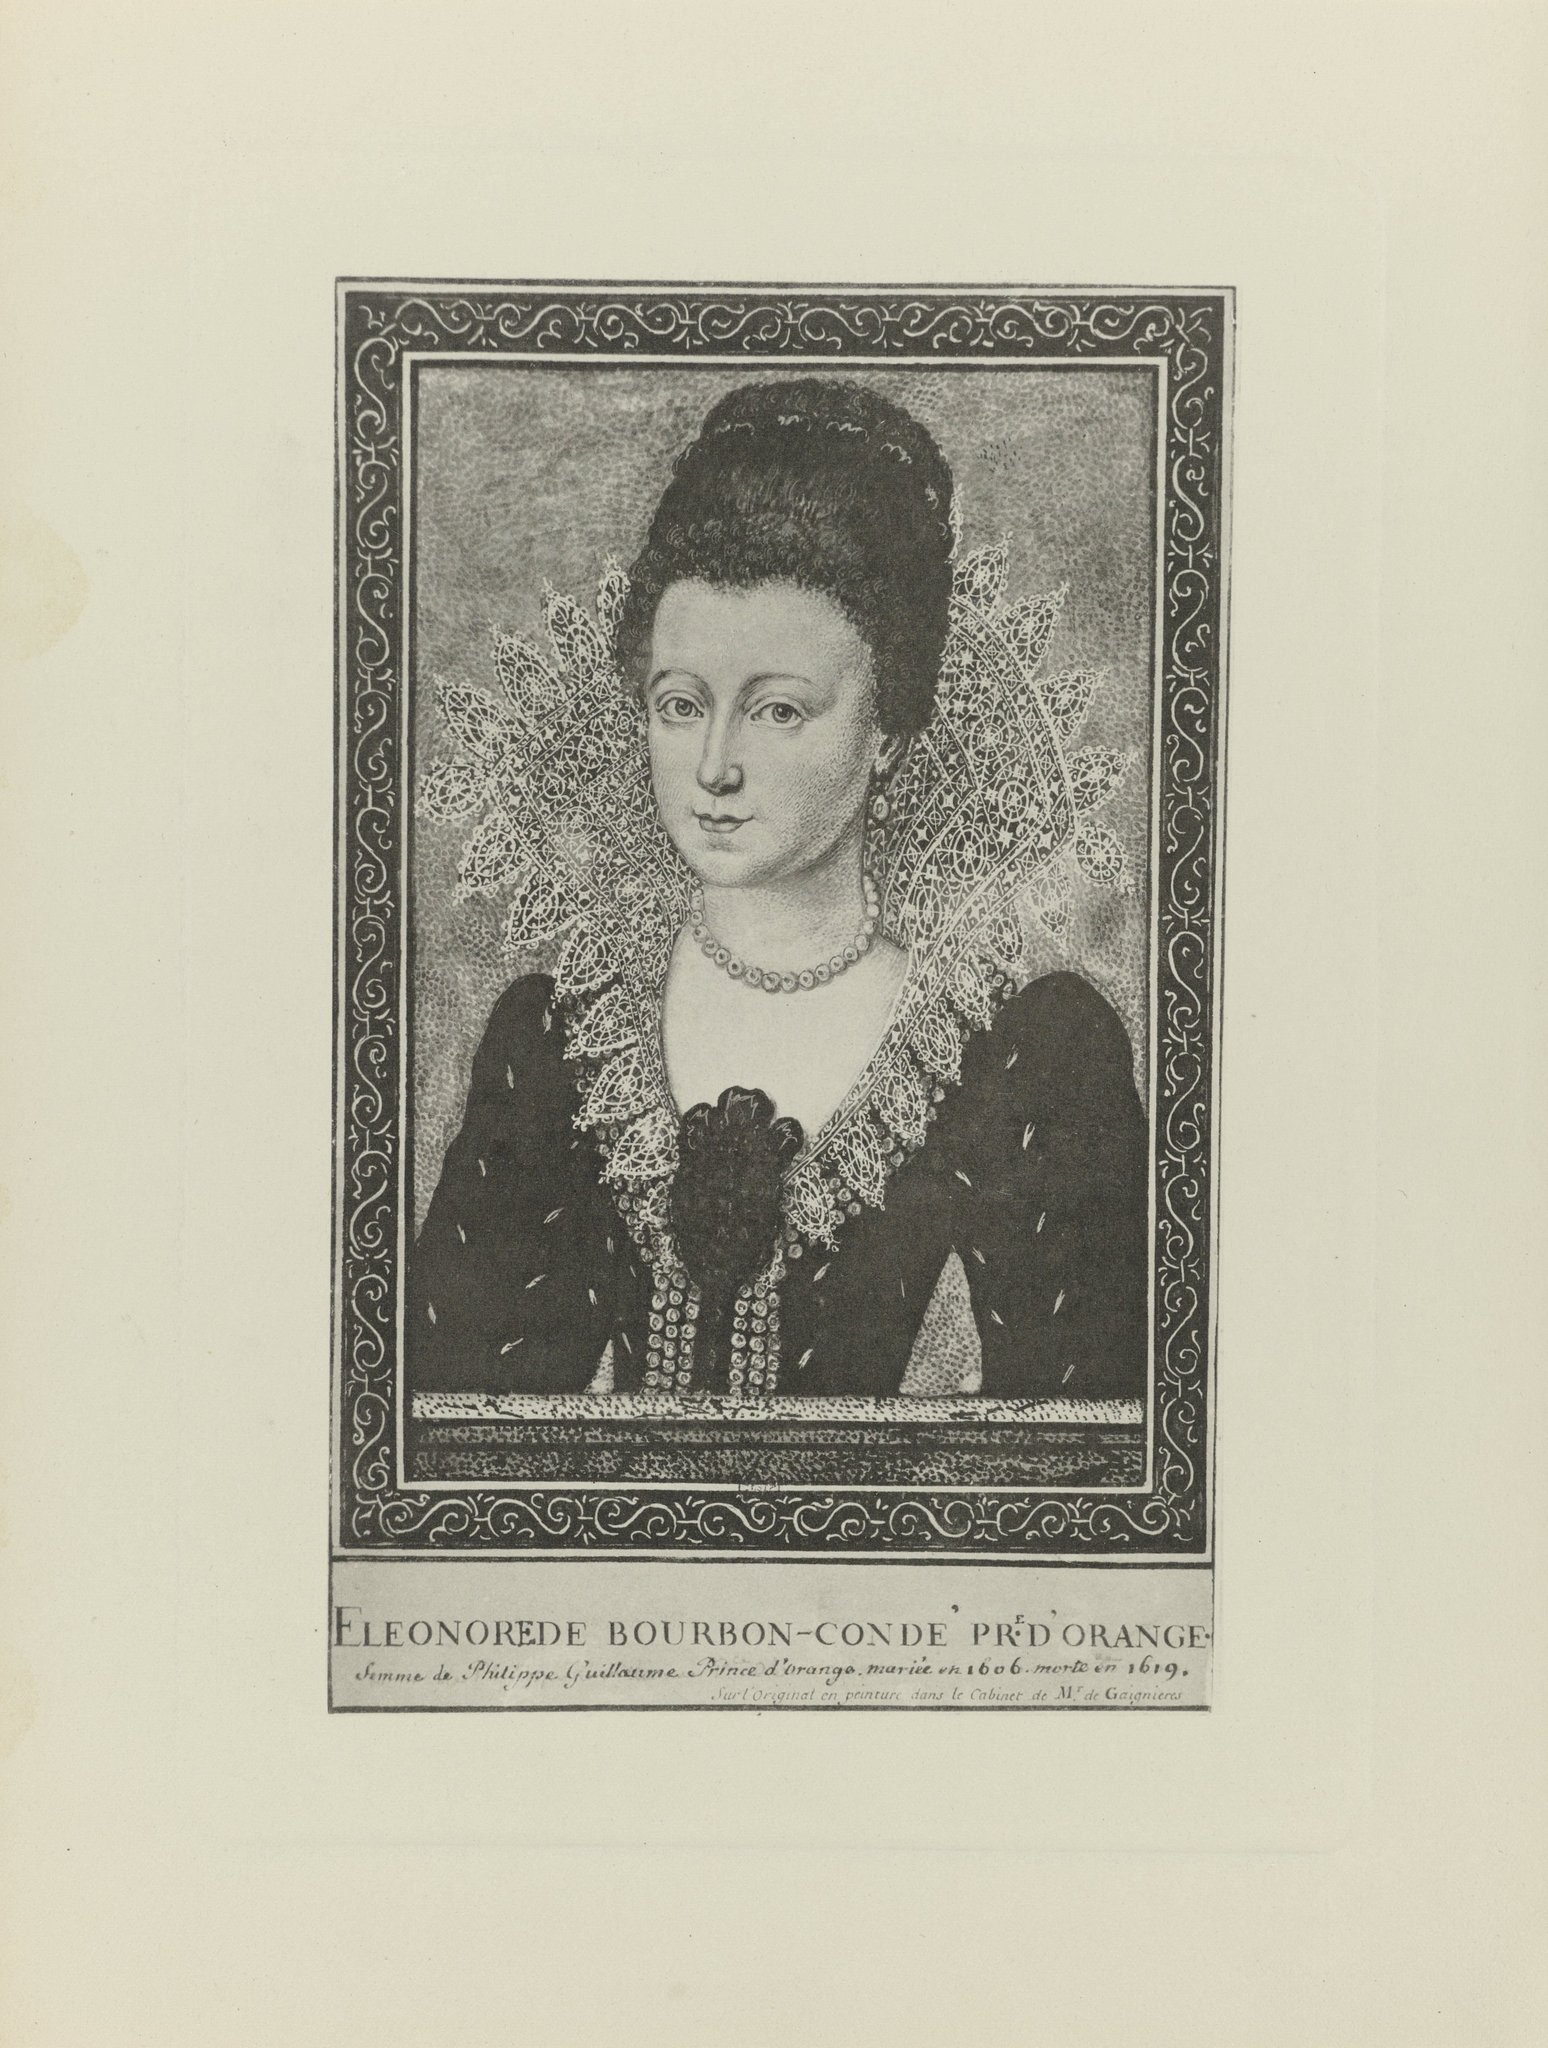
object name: photomechanical print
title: Portret van Eleonora van Bourbon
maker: Anonymous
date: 1850-1949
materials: paper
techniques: photochemical processes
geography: netherlands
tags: éléonore de bourbon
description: Portret van Eleonora in een geornamenteerde lijst. In een kader haar naam.